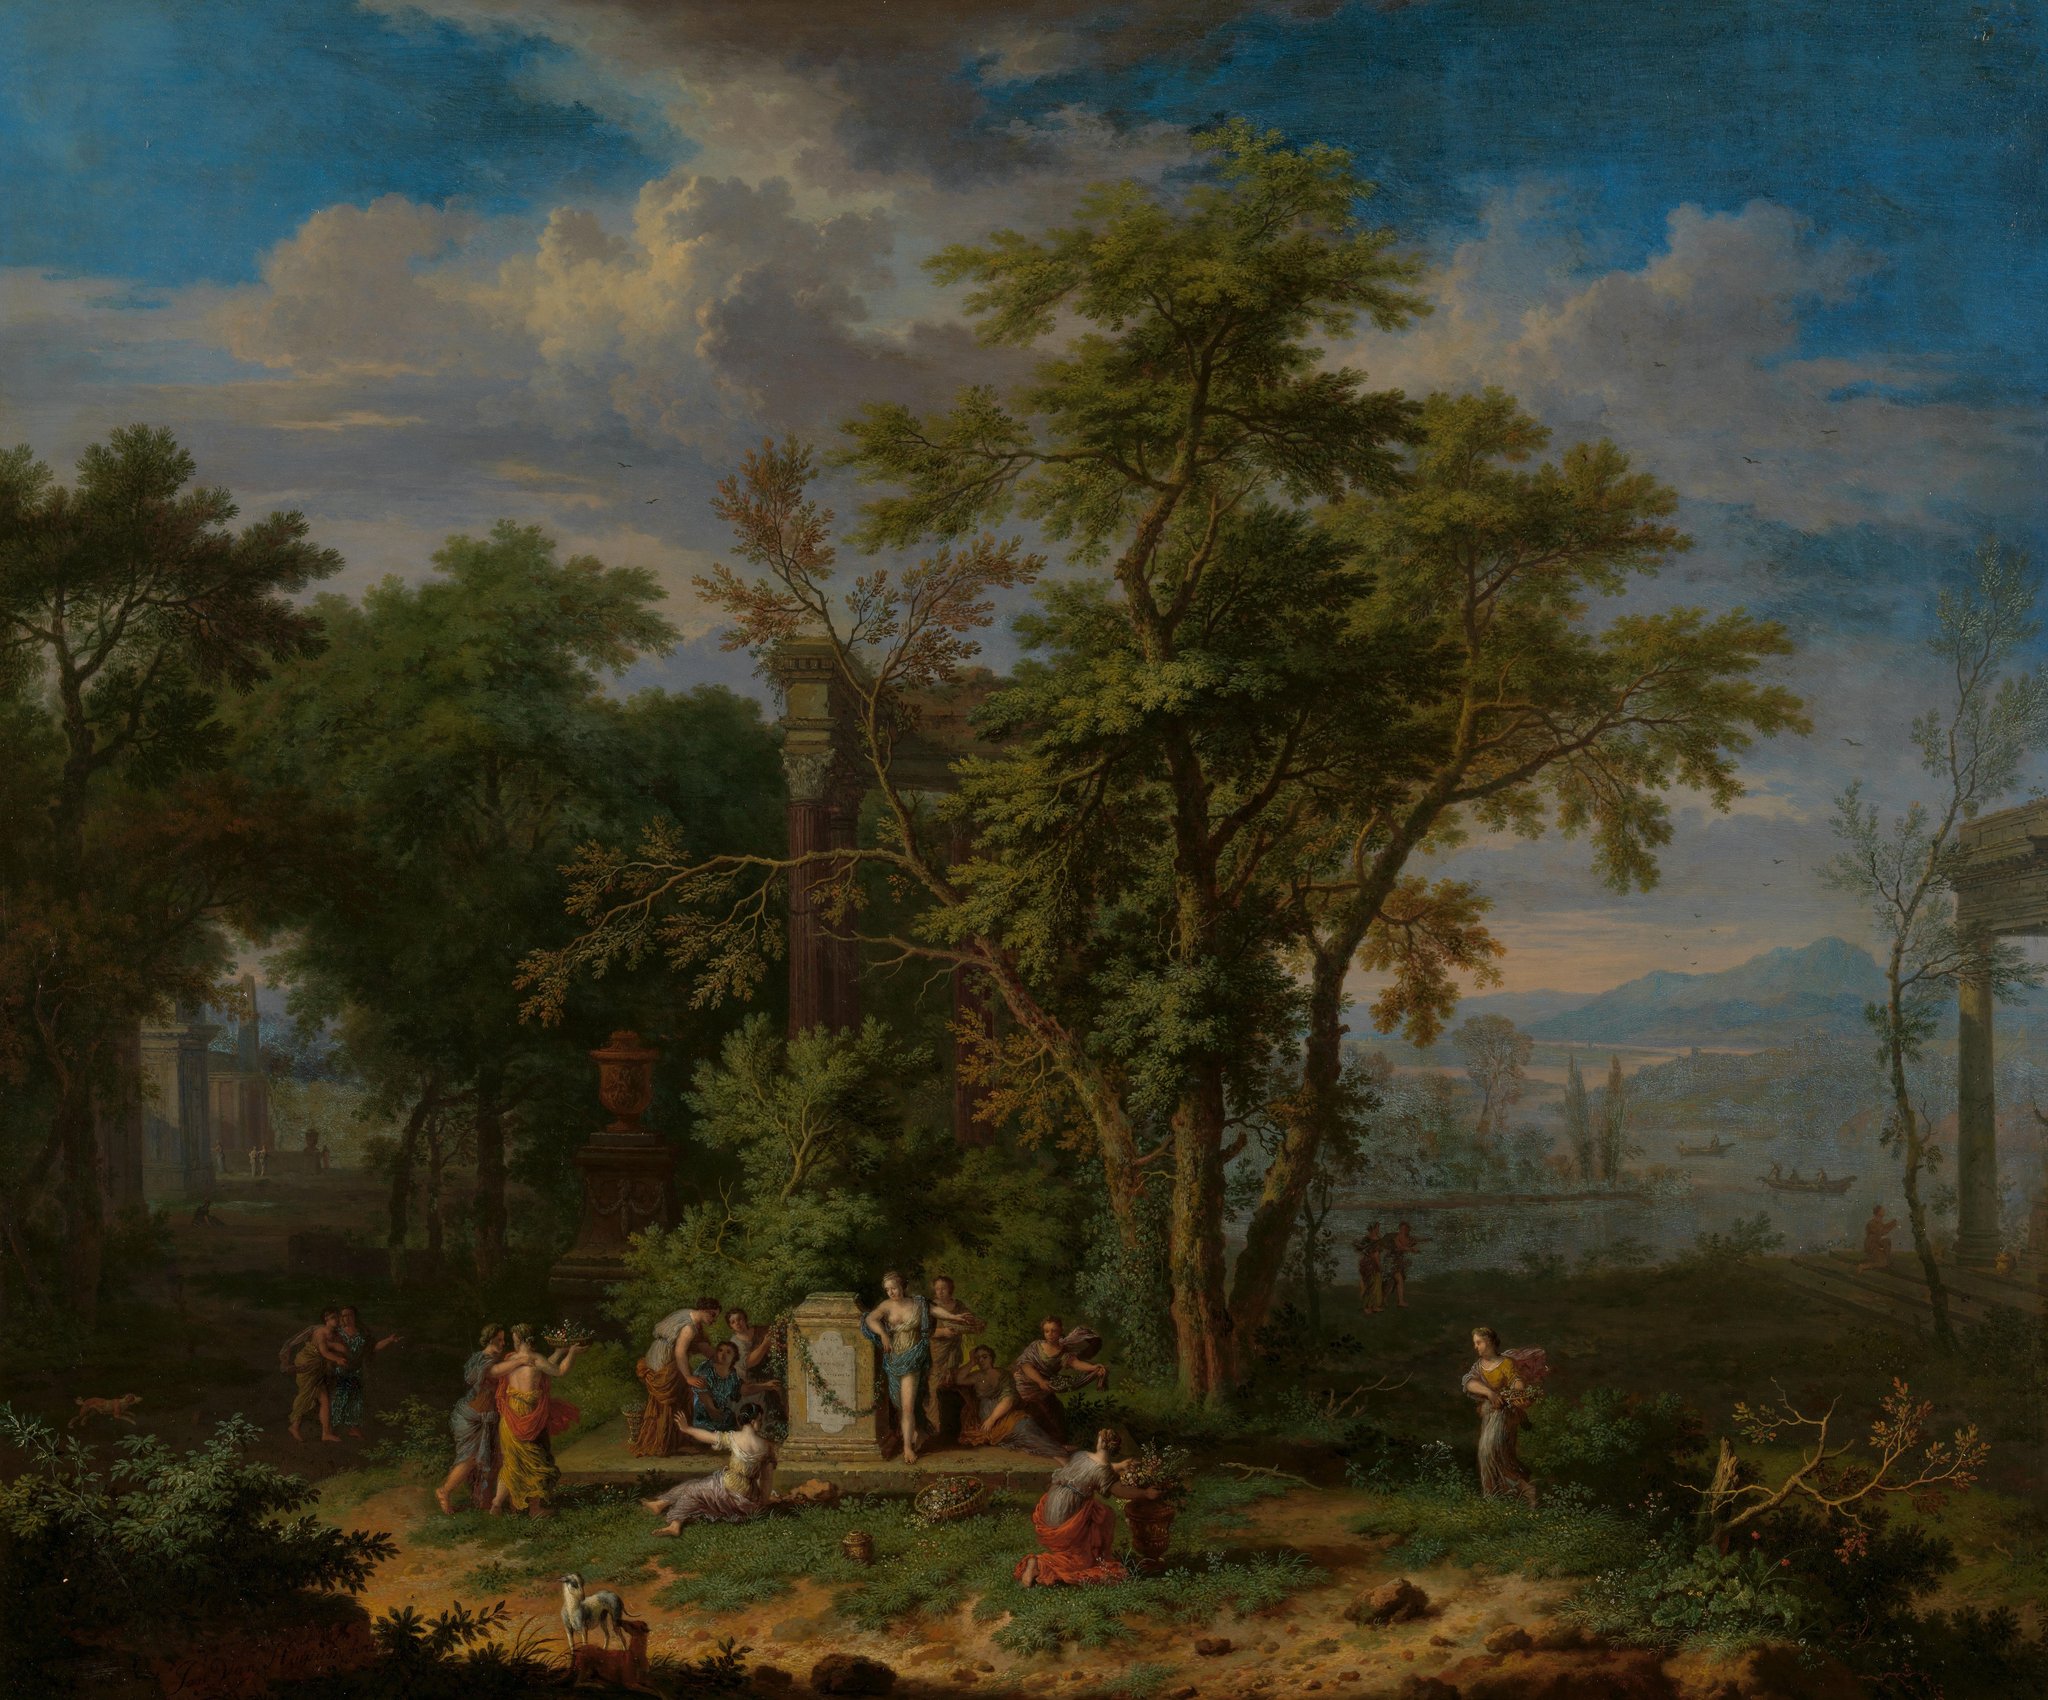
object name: painting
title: Arcadian Landscape with a Sacrificial Feast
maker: jan van huysum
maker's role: draughtsman, painter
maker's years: 1682-1749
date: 1700-1749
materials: copper, oil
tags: pastorals, arcadian scenes, altar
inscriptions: signature and date: ‘Jan V. Huysum fecit’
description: These two scenes are painted on copper, a support that allowed Van Huysum to achieve a remarkably smooth and shiny result. Depicted are Arcadian, or idyllic, landscapes, with temples and figures from Classical antiquity. They are small gems intended for an art lover’s collection.